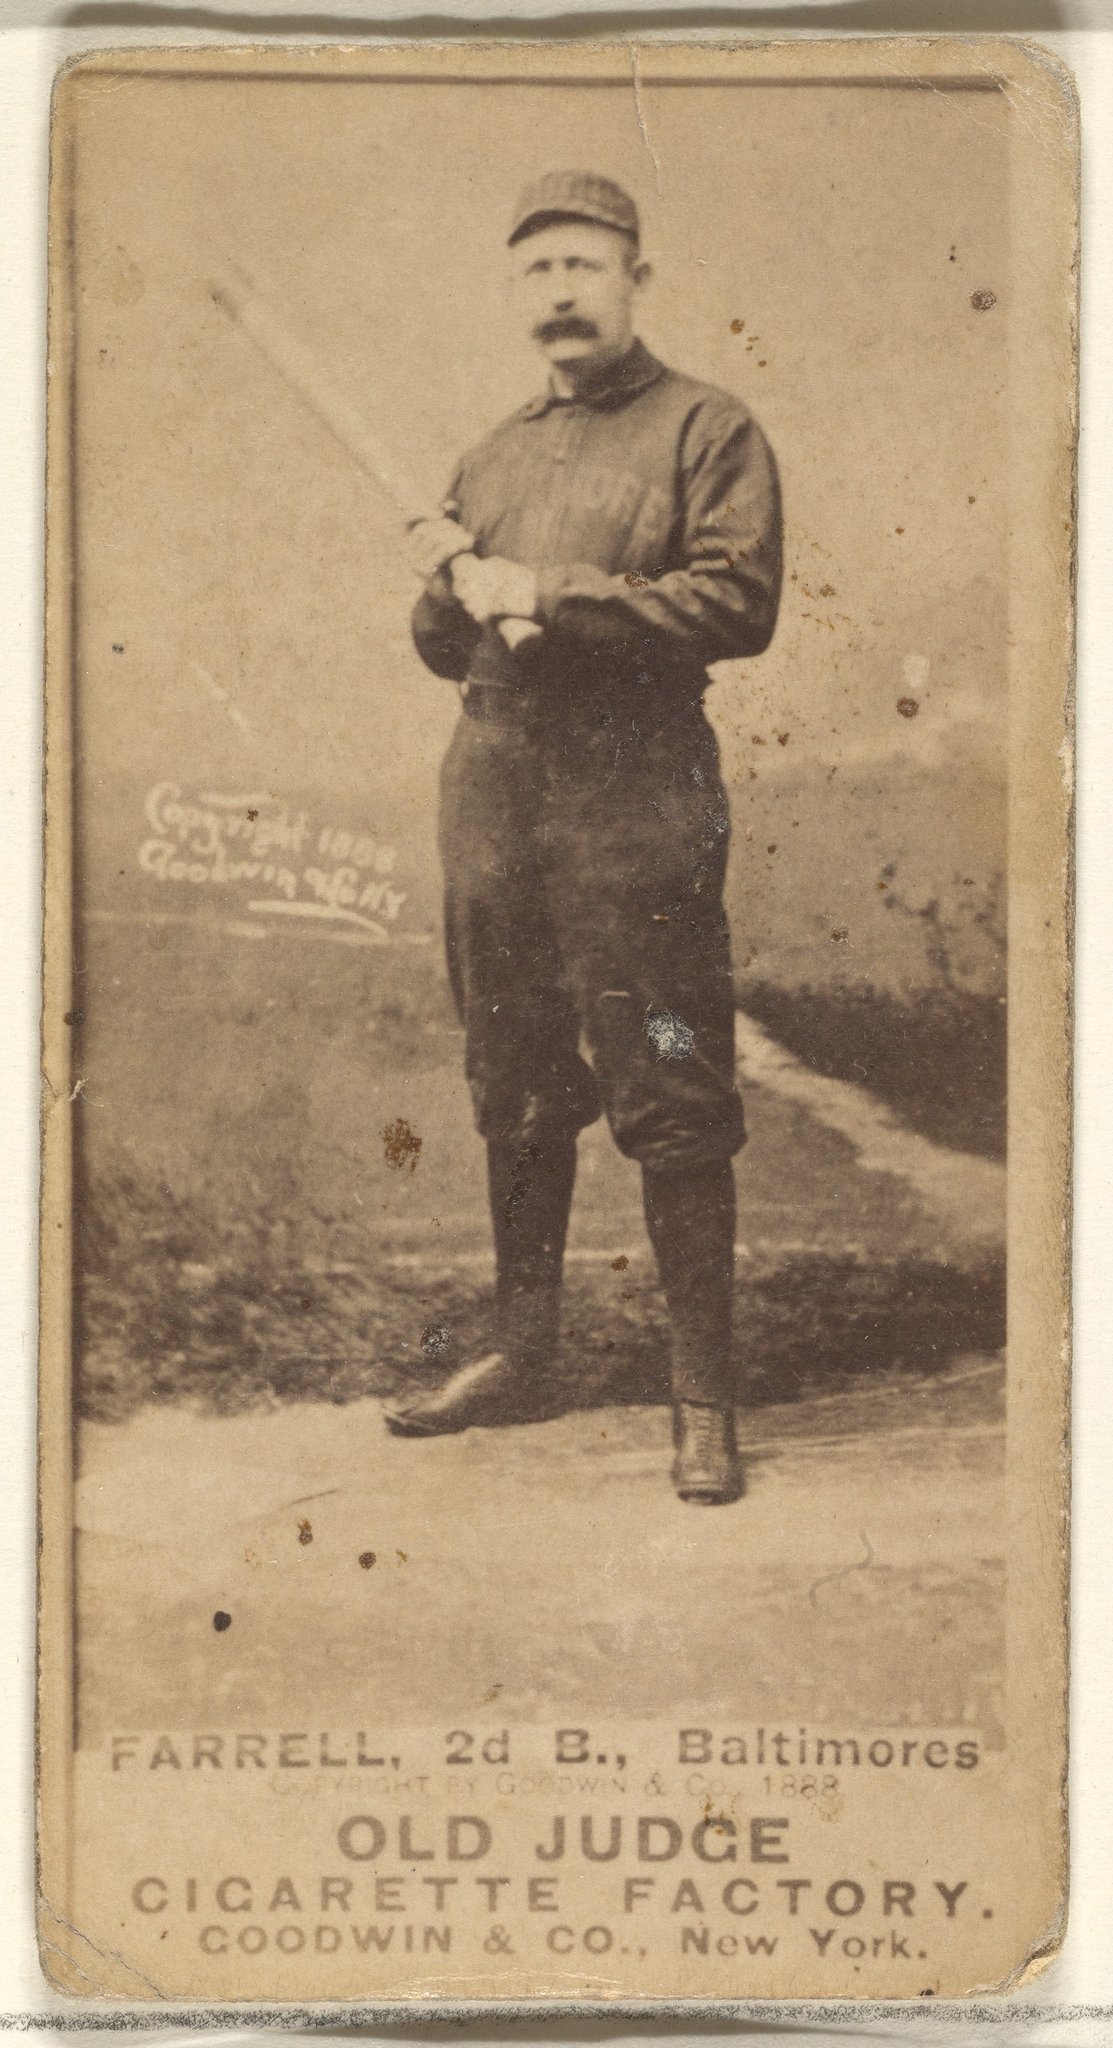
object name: baseball card, photograph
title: Farrell, 2nd Base, Baltimore Orioles, from the Old Judge series (N172) for Old Judge Cigarettes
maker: goodwin & company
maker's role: publisher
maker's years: 1850-1950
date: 1888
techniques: albumen silver print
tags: men,portraits,baseball,athletes